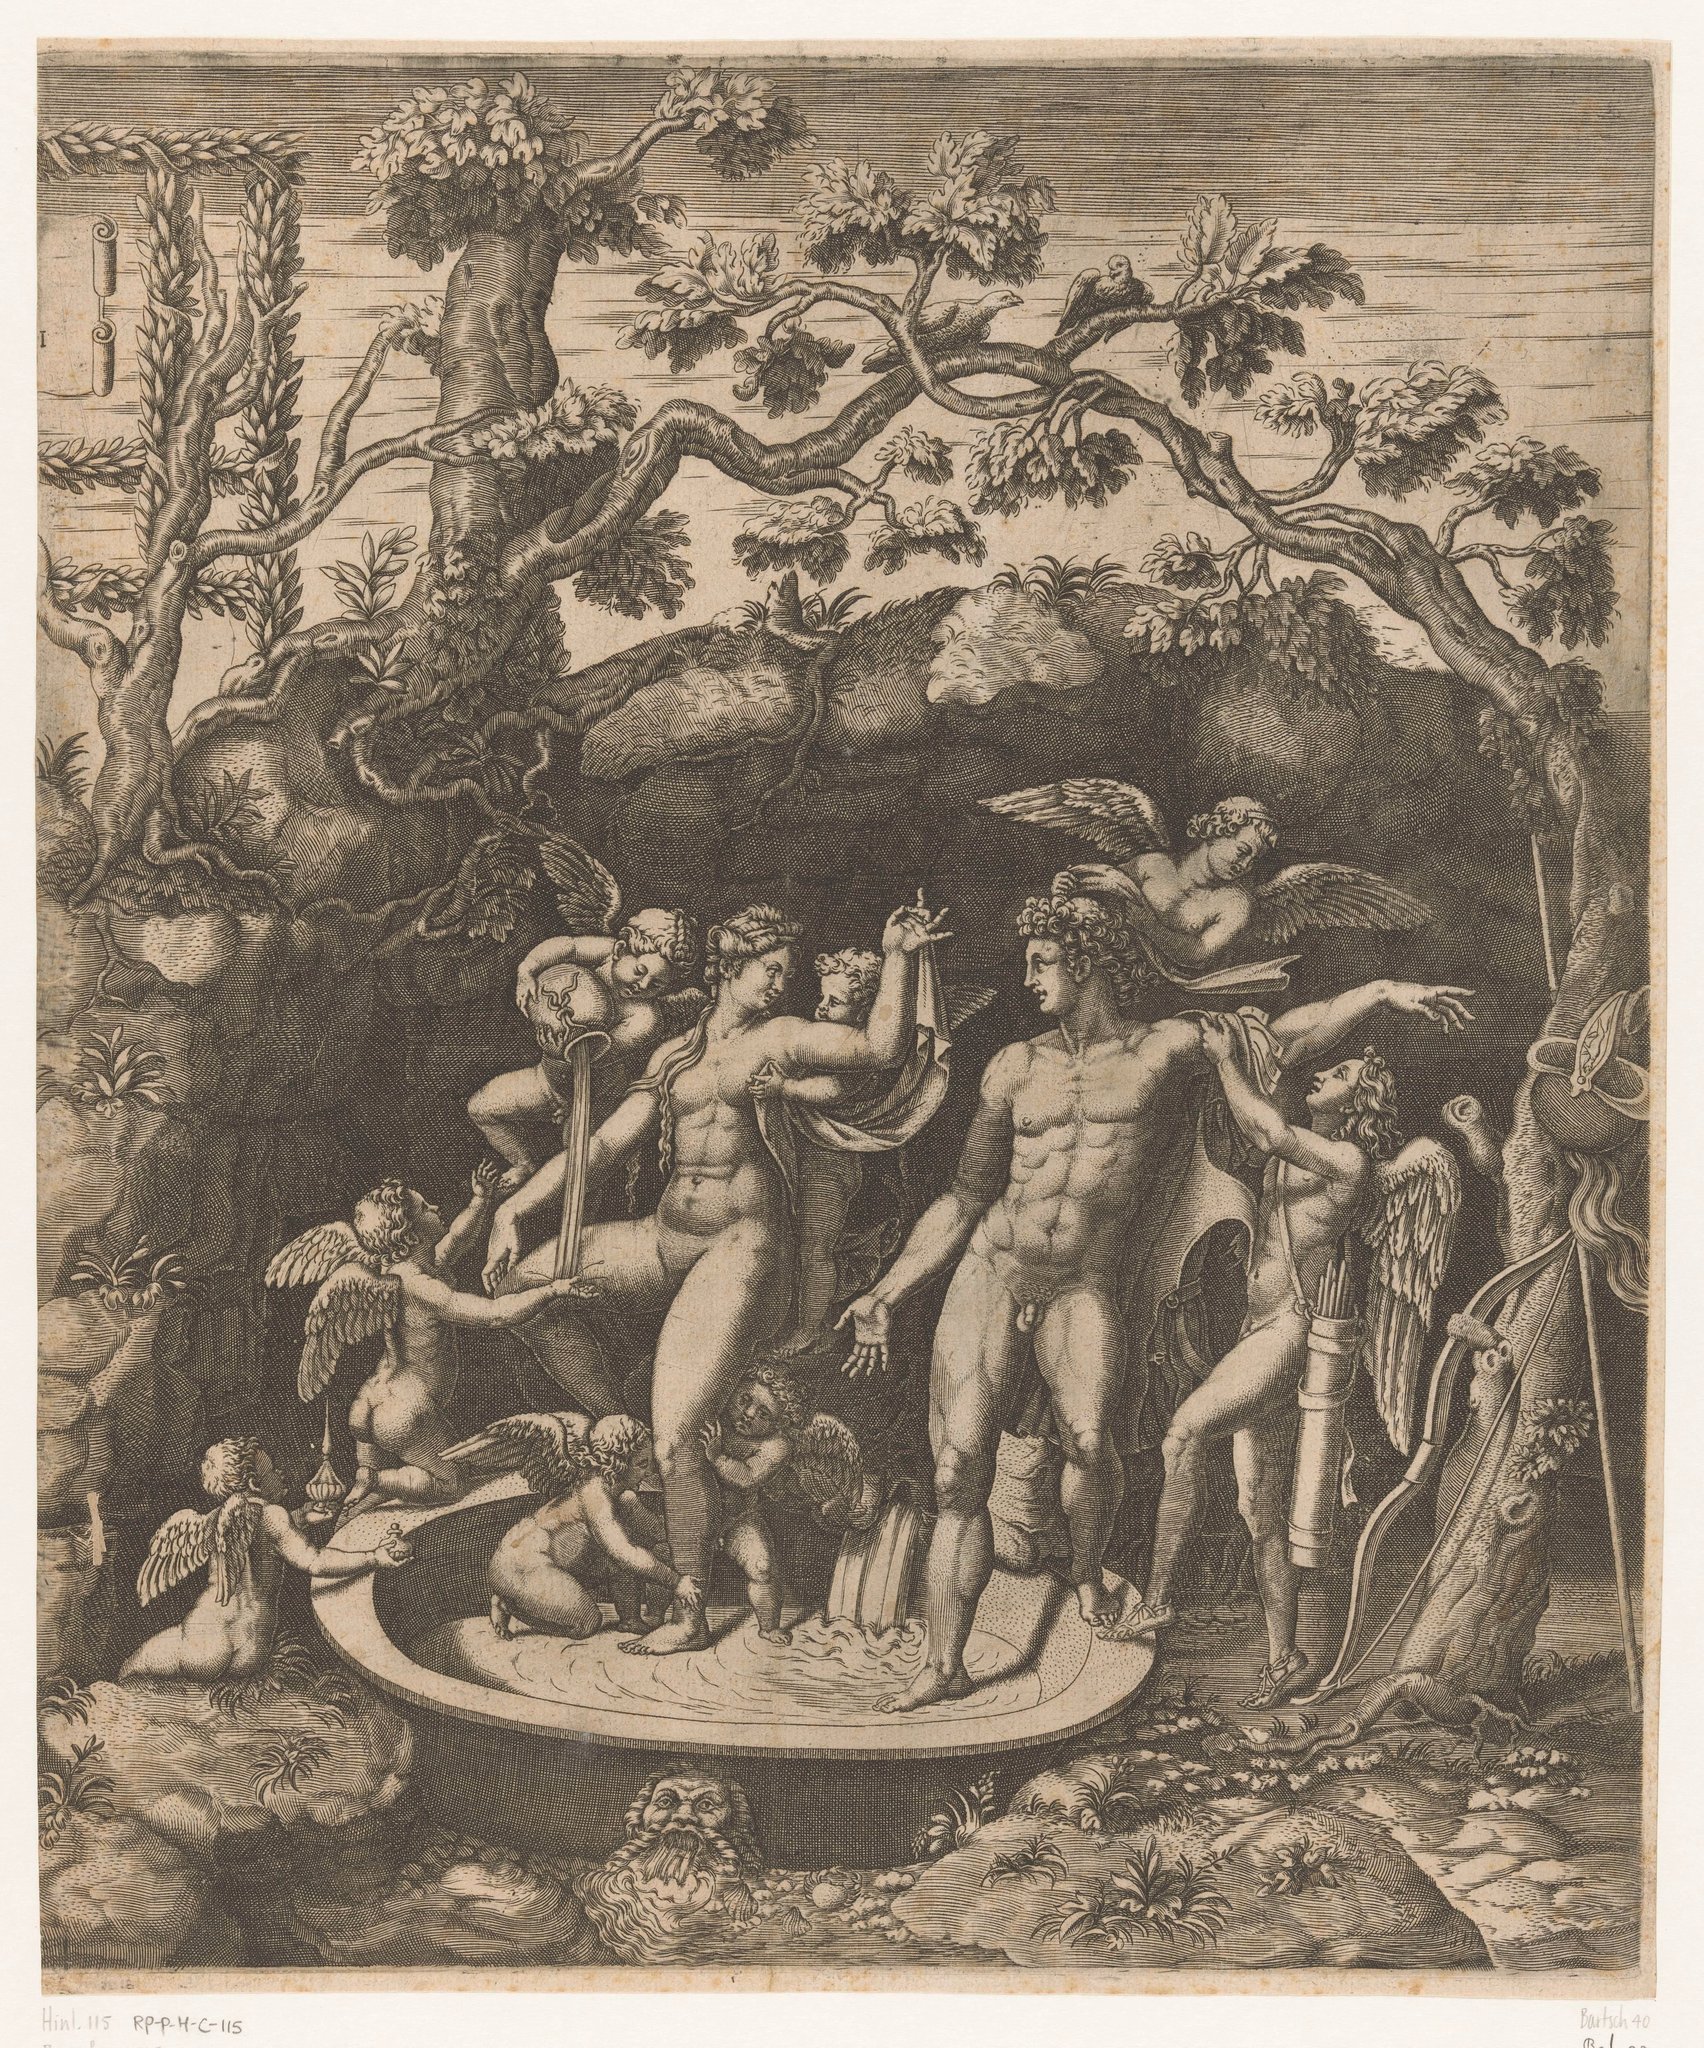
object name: print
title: Voorbereidingen voor het huwelijksfeest van Amor en Psyche (rechterdeel)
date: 1575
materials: paper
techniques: engraving, etching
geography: italy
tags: helmet, bath of venus and mars, washing and bathing, archer's weapons: bow, cupids: 'amores', 'amoretti', 'putti'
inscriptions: collector's mark: ‘Hinloopen’, collector's mark: Lugt 10, collector's mark: Lugt 11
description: In een bassin voor een grot staan een naakte god en godin, mogelijk Mars en Venus. De twee goden worden gewassen door putti.